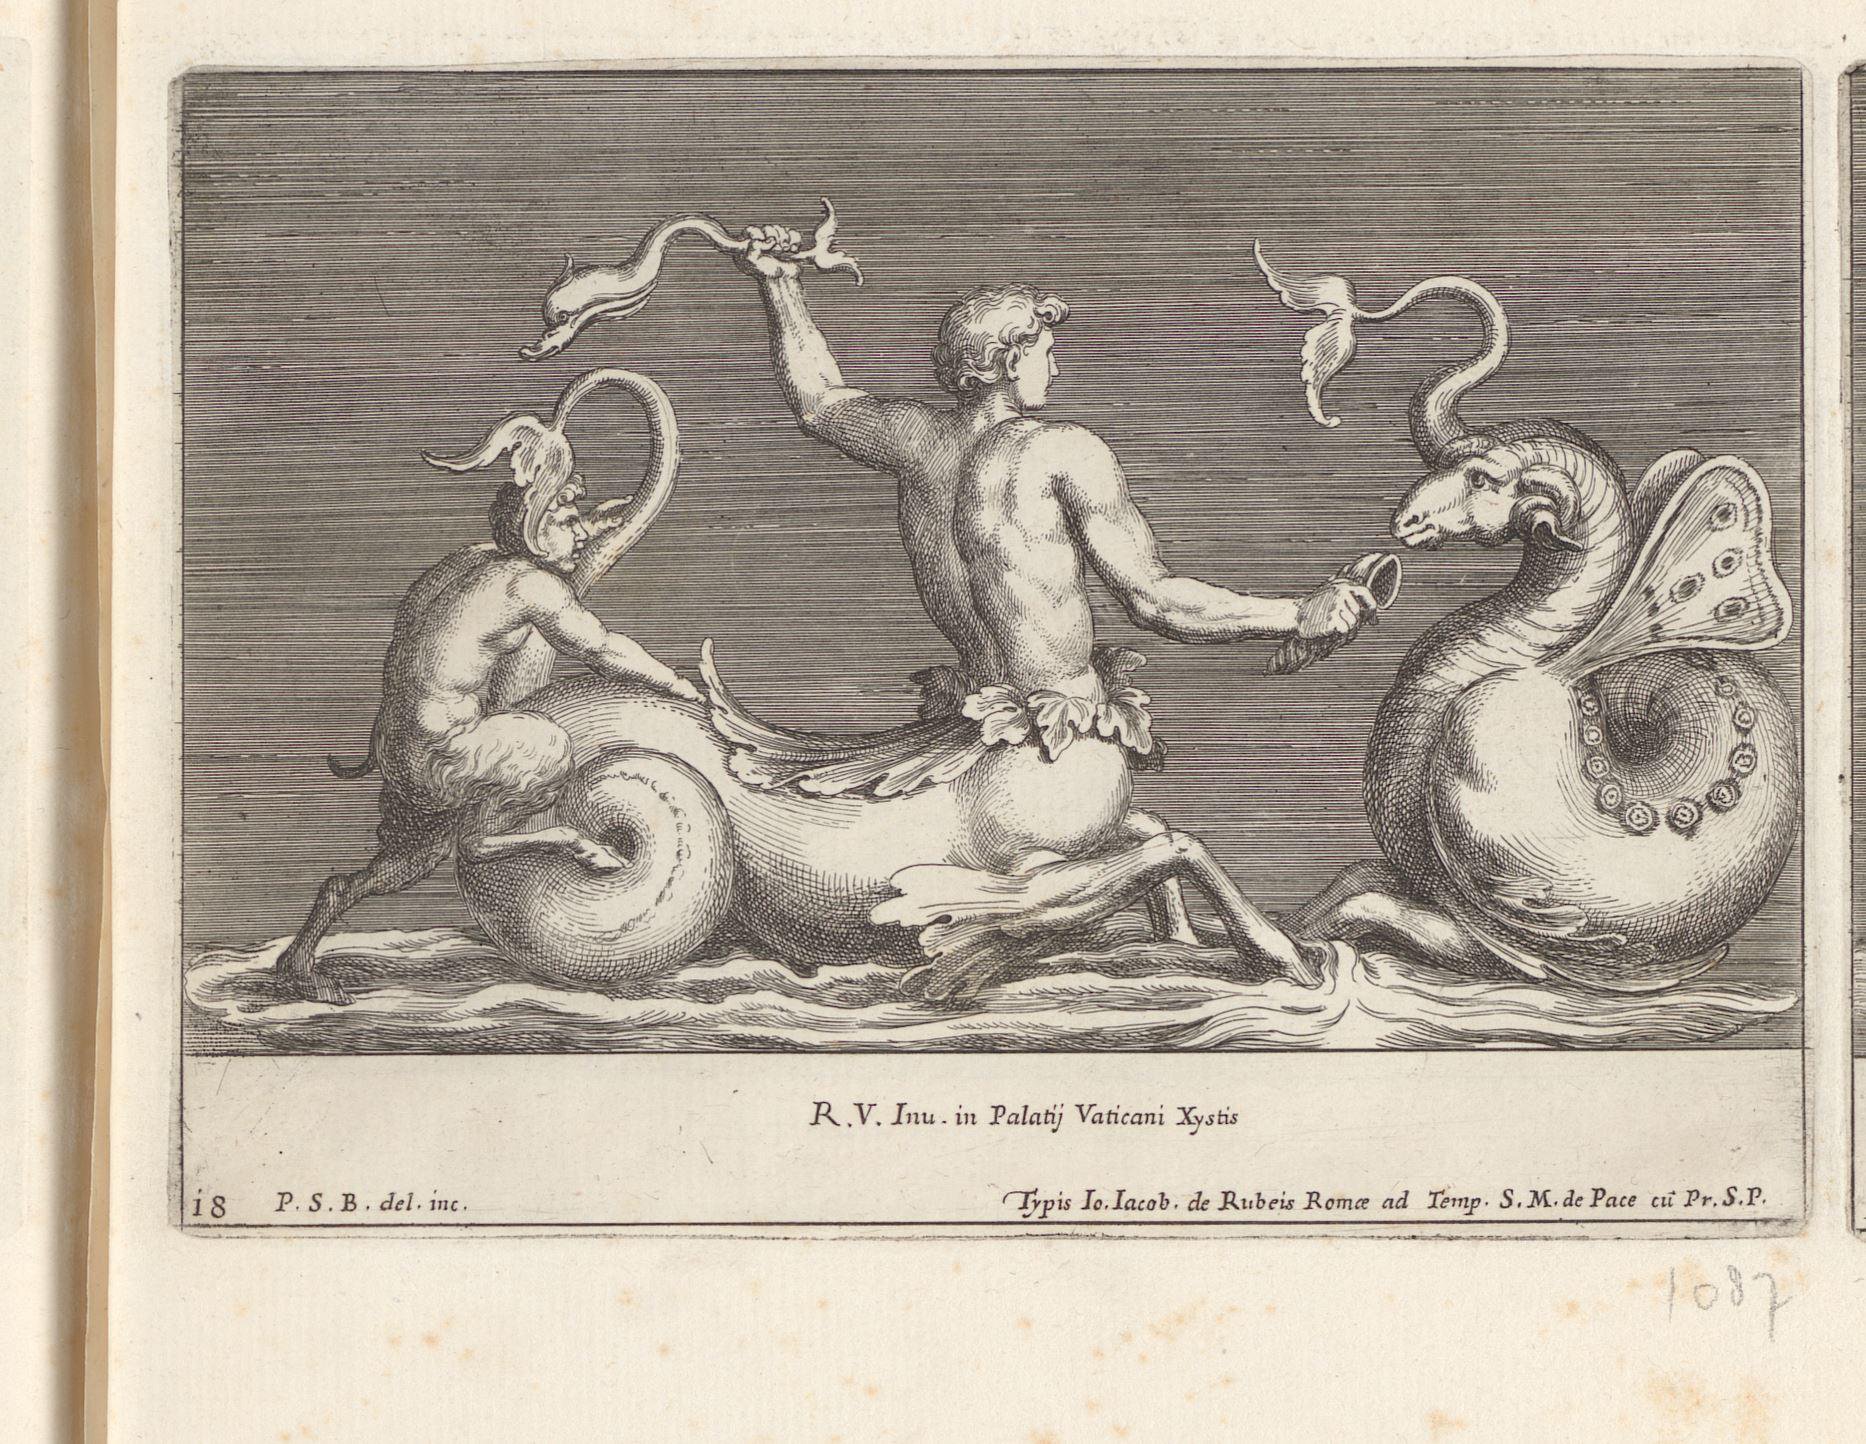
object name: album leaf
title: Reliëfs in de Loggia van Rafaël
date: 1645-1700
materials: paper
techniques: engraving, etching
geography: vatican city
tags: triton(s), monsters of the sea, satyr(s) (in general)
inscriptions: number: ‘45’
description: Prent uit een reeks naar de gipsen reliëfs door Rafaël en uitgevoerd door zijn assistenten in de Vaticaanse Loggia.